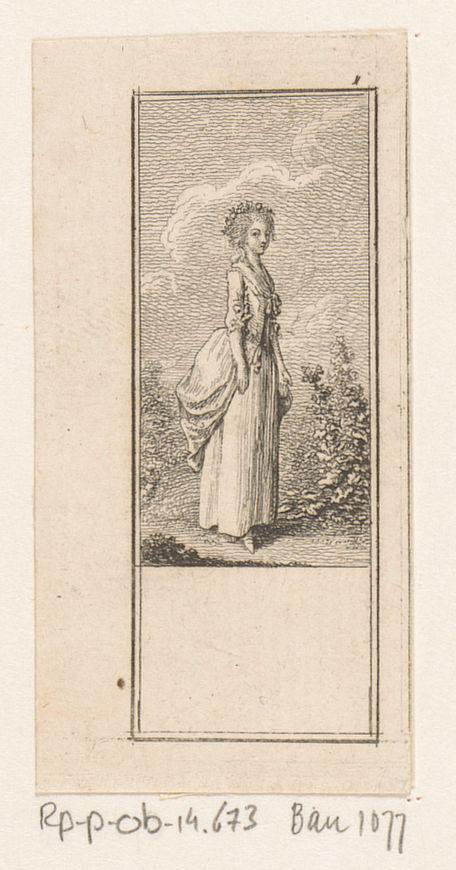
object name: print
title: beminnelijkheid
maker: daniel nikolaus chodowiecki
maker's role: draughtsman, print maker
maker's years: 1726-1801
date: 1784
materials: paper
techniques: etching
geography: berlin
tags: good and bad behaviour, moral qualities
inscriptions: collector's mark: Lugt 2228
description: Latere staat gebruikt voor: Kleinen Taschen Calender auf das gemeine Jahr 1785 (...). Berlijn: S.n., 1784.